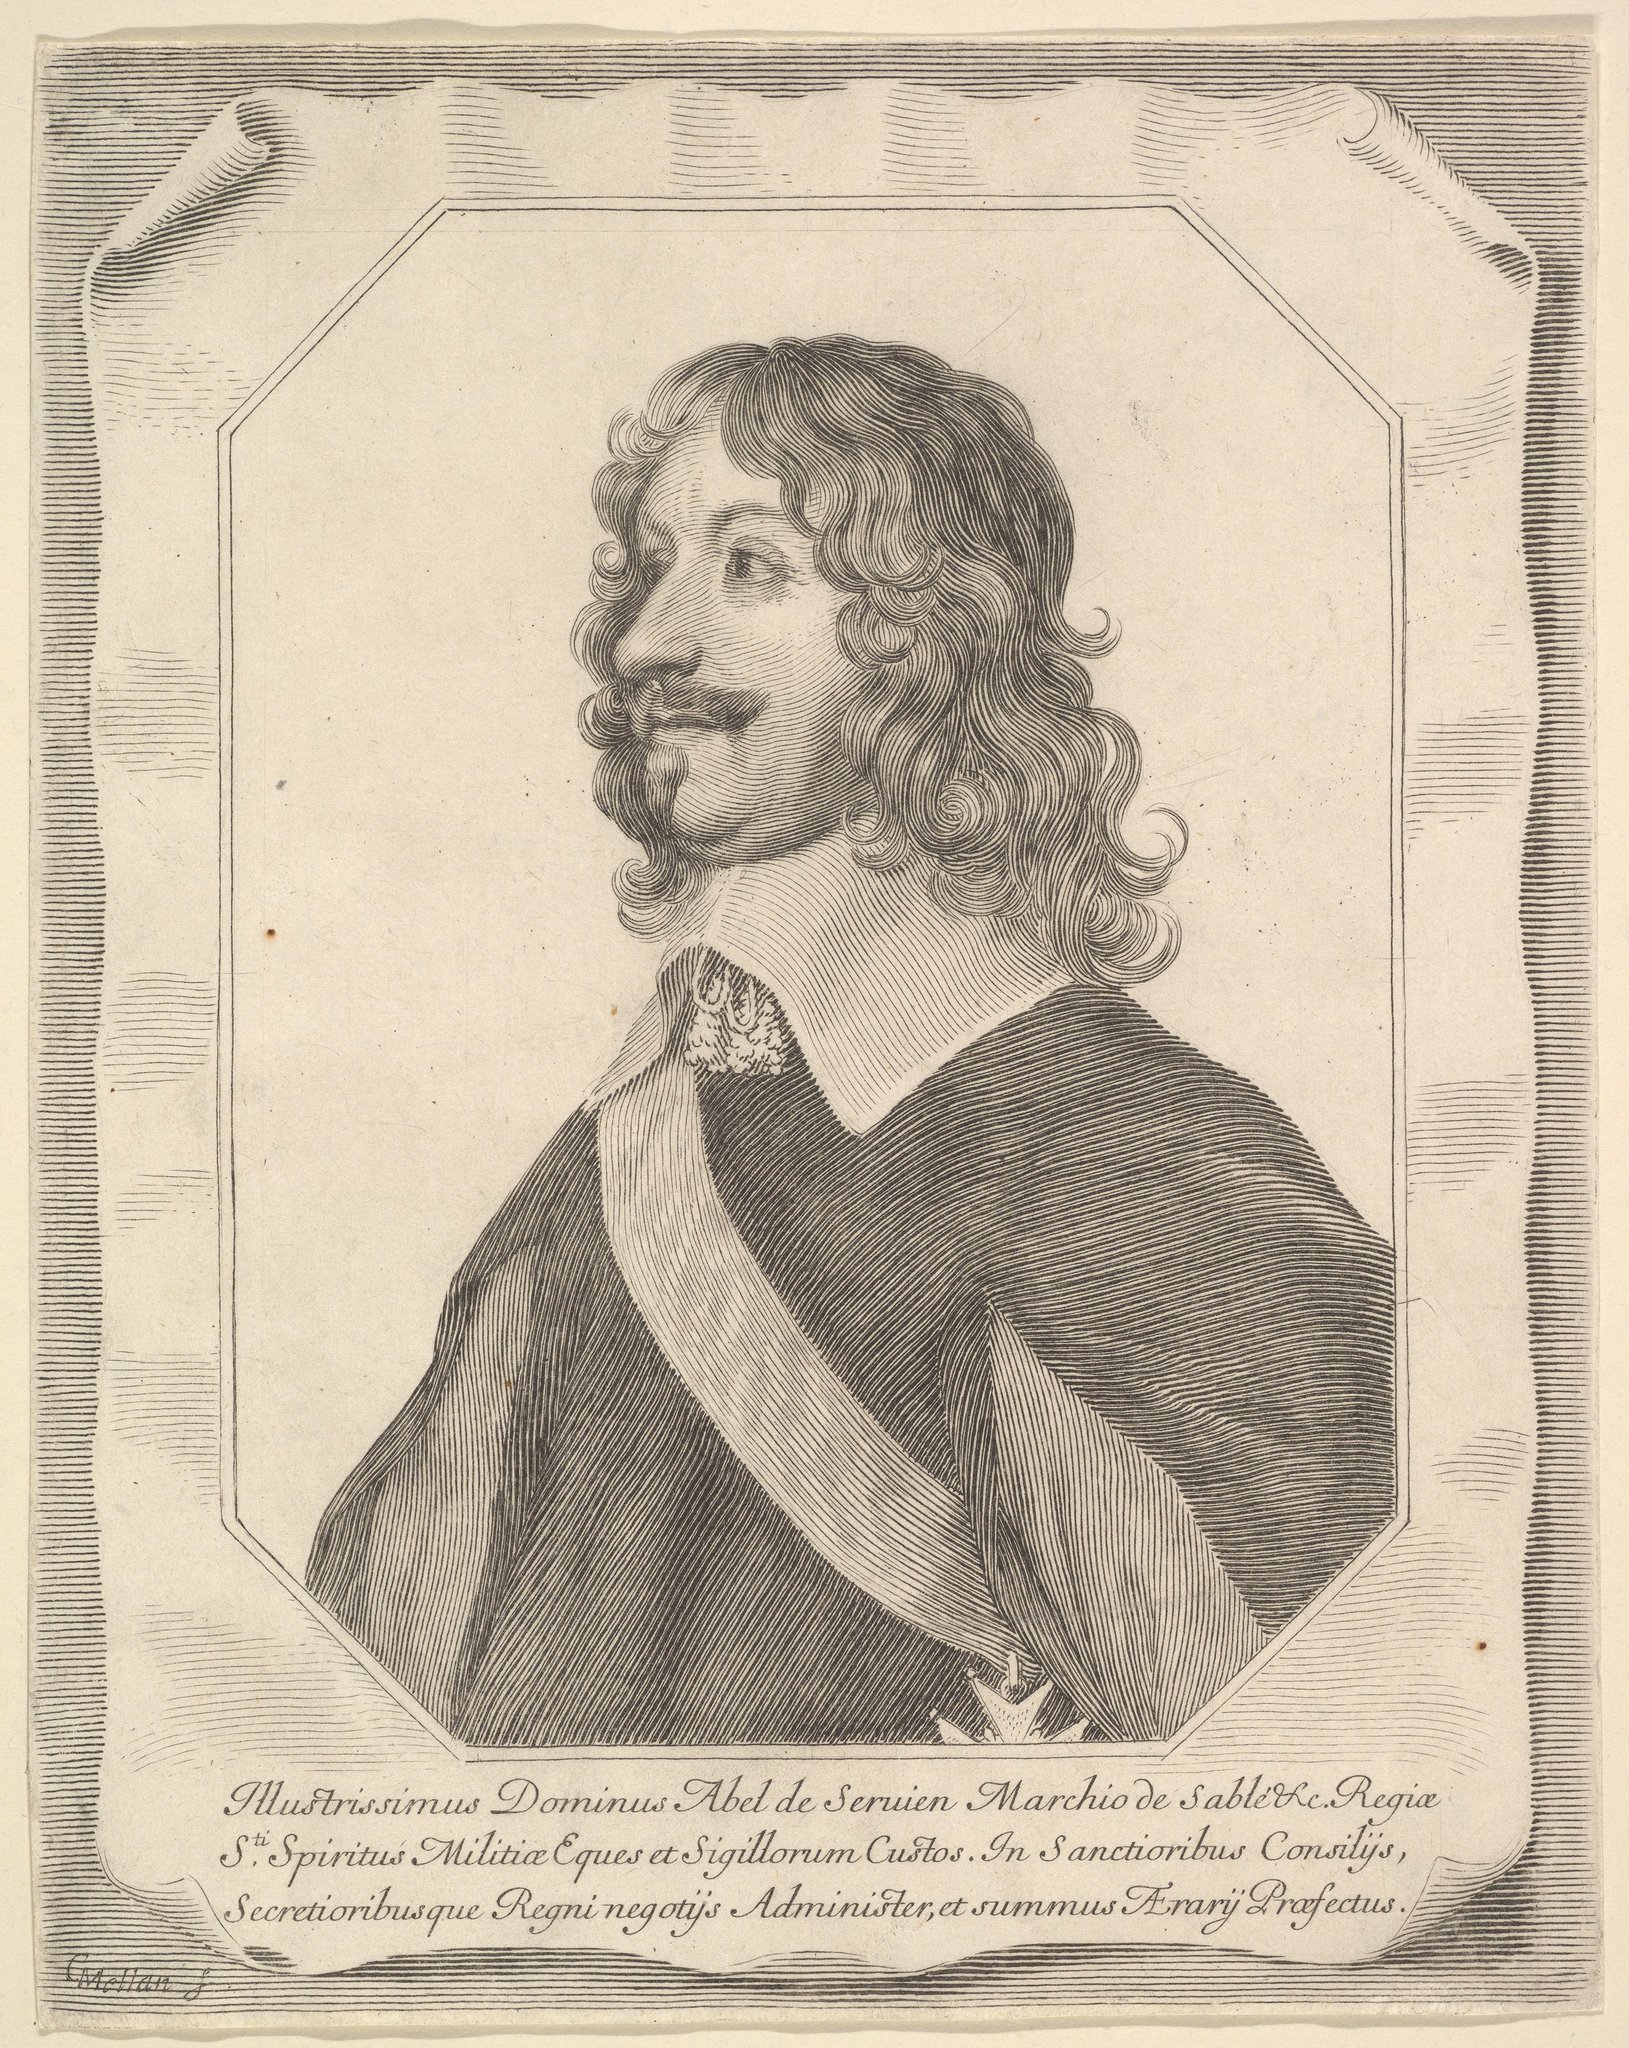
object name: print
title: Abel Servien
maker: claude mellan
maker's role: artist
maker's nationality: french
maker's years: 1598-1688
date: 1650-1659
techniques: engraving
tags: men,portraits